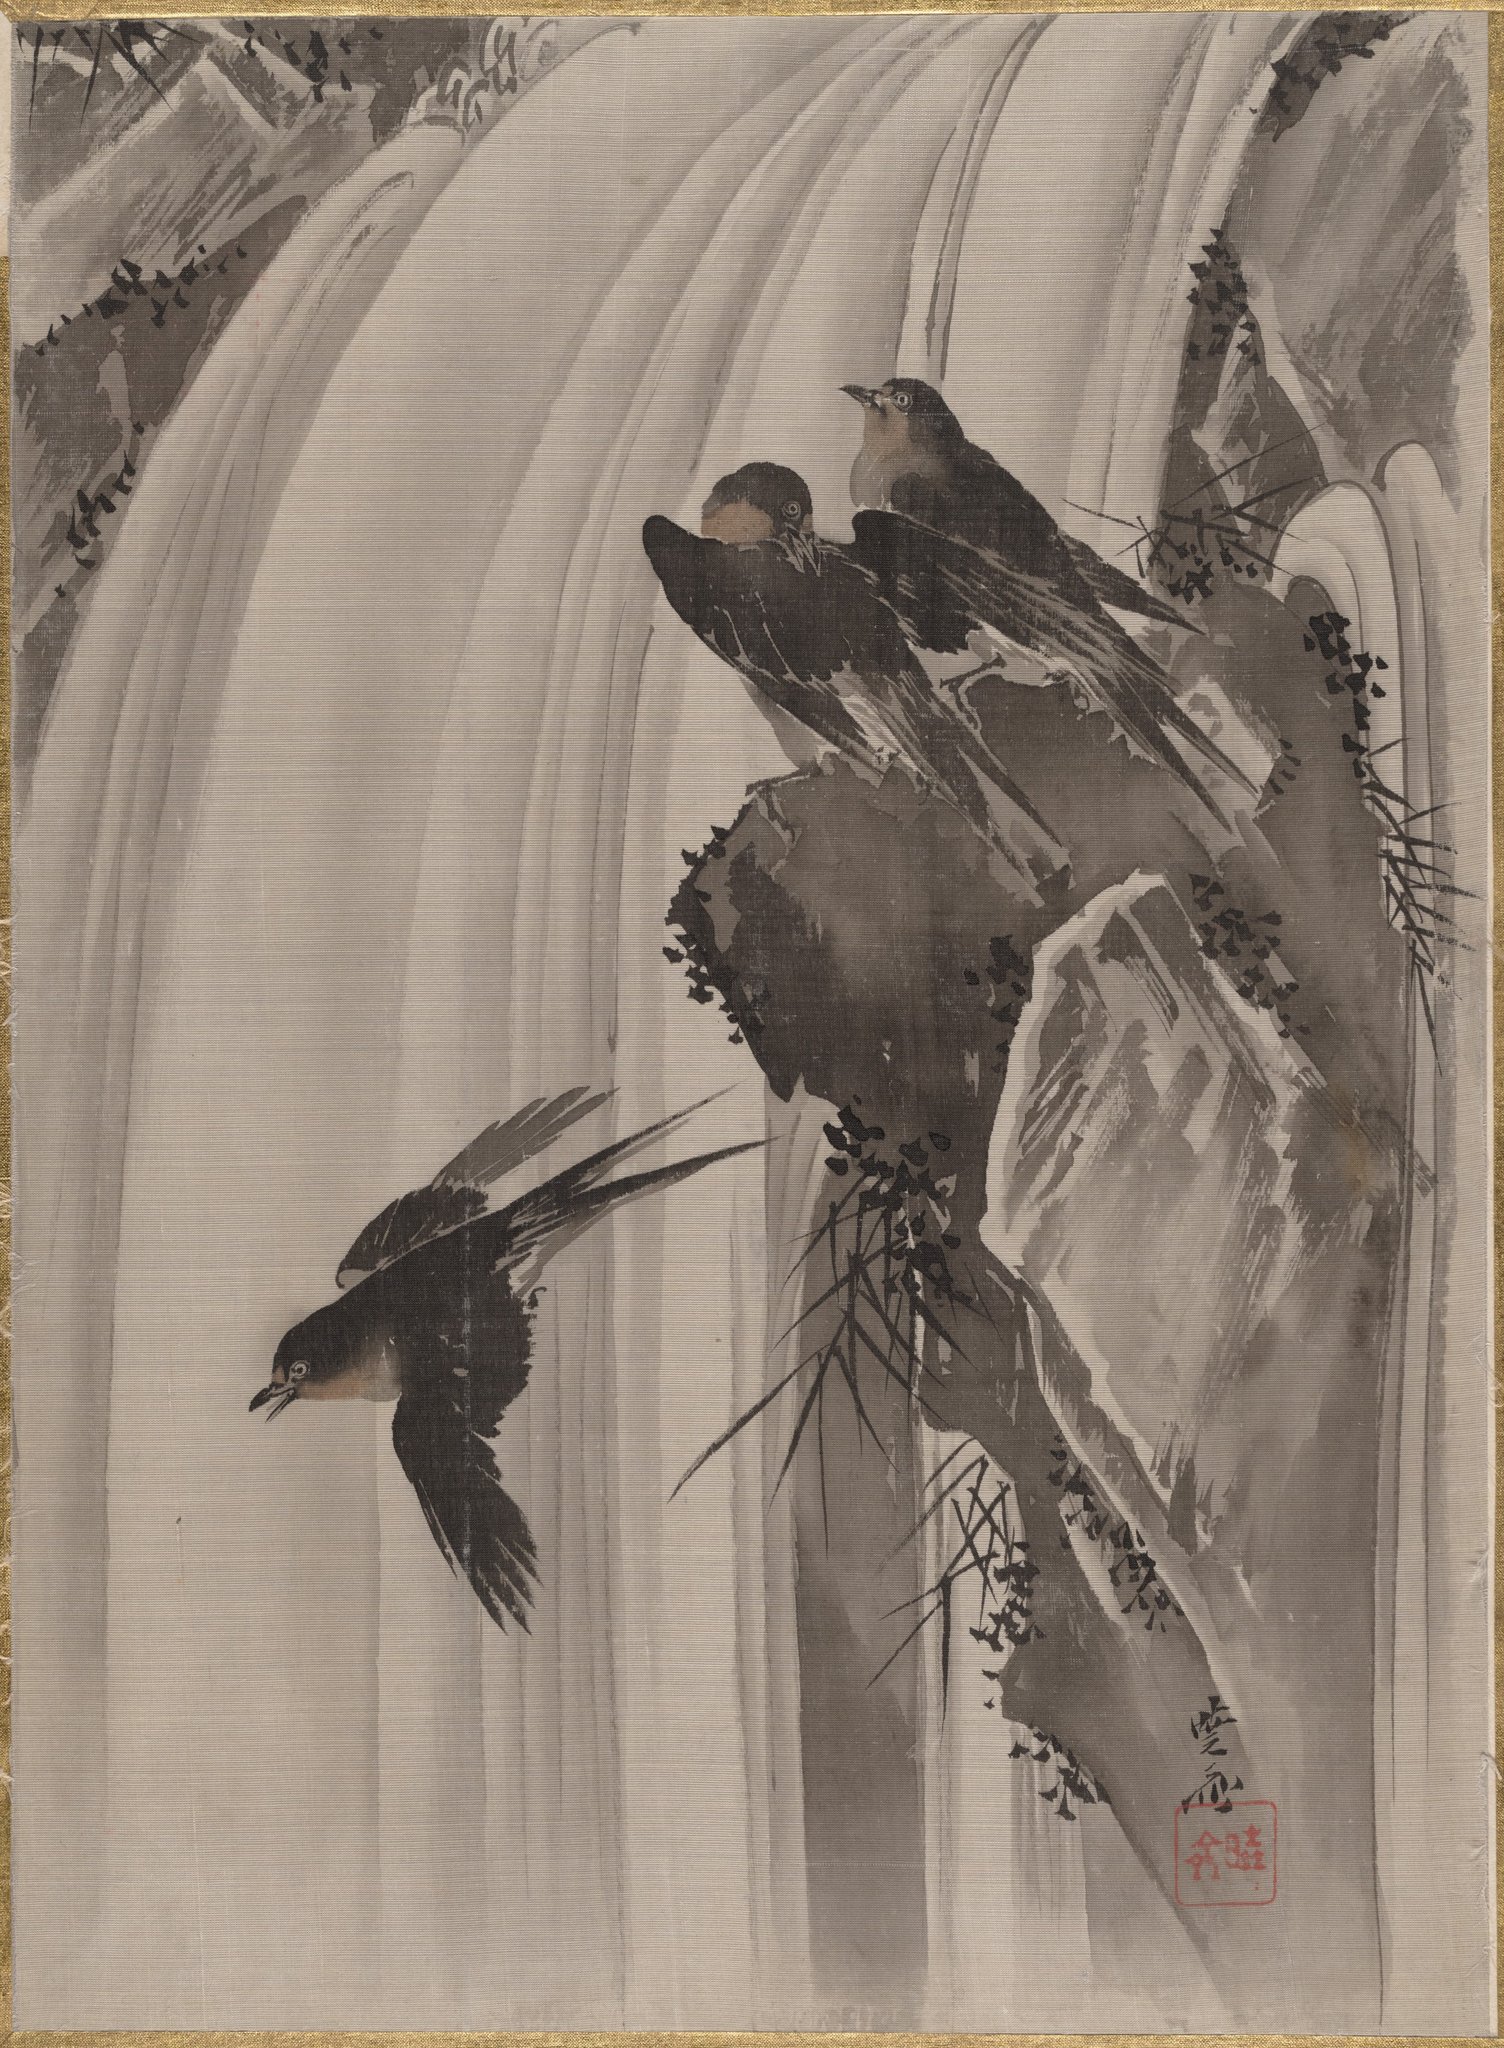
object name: album leaf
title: Swallows by a Waterfall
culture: japanese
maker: kawanabe kyōsai 河鍋暁斎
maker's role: artist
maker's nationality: japanese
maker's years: 1831-1889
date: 1887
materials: ink, silk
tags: birds,waterfalls